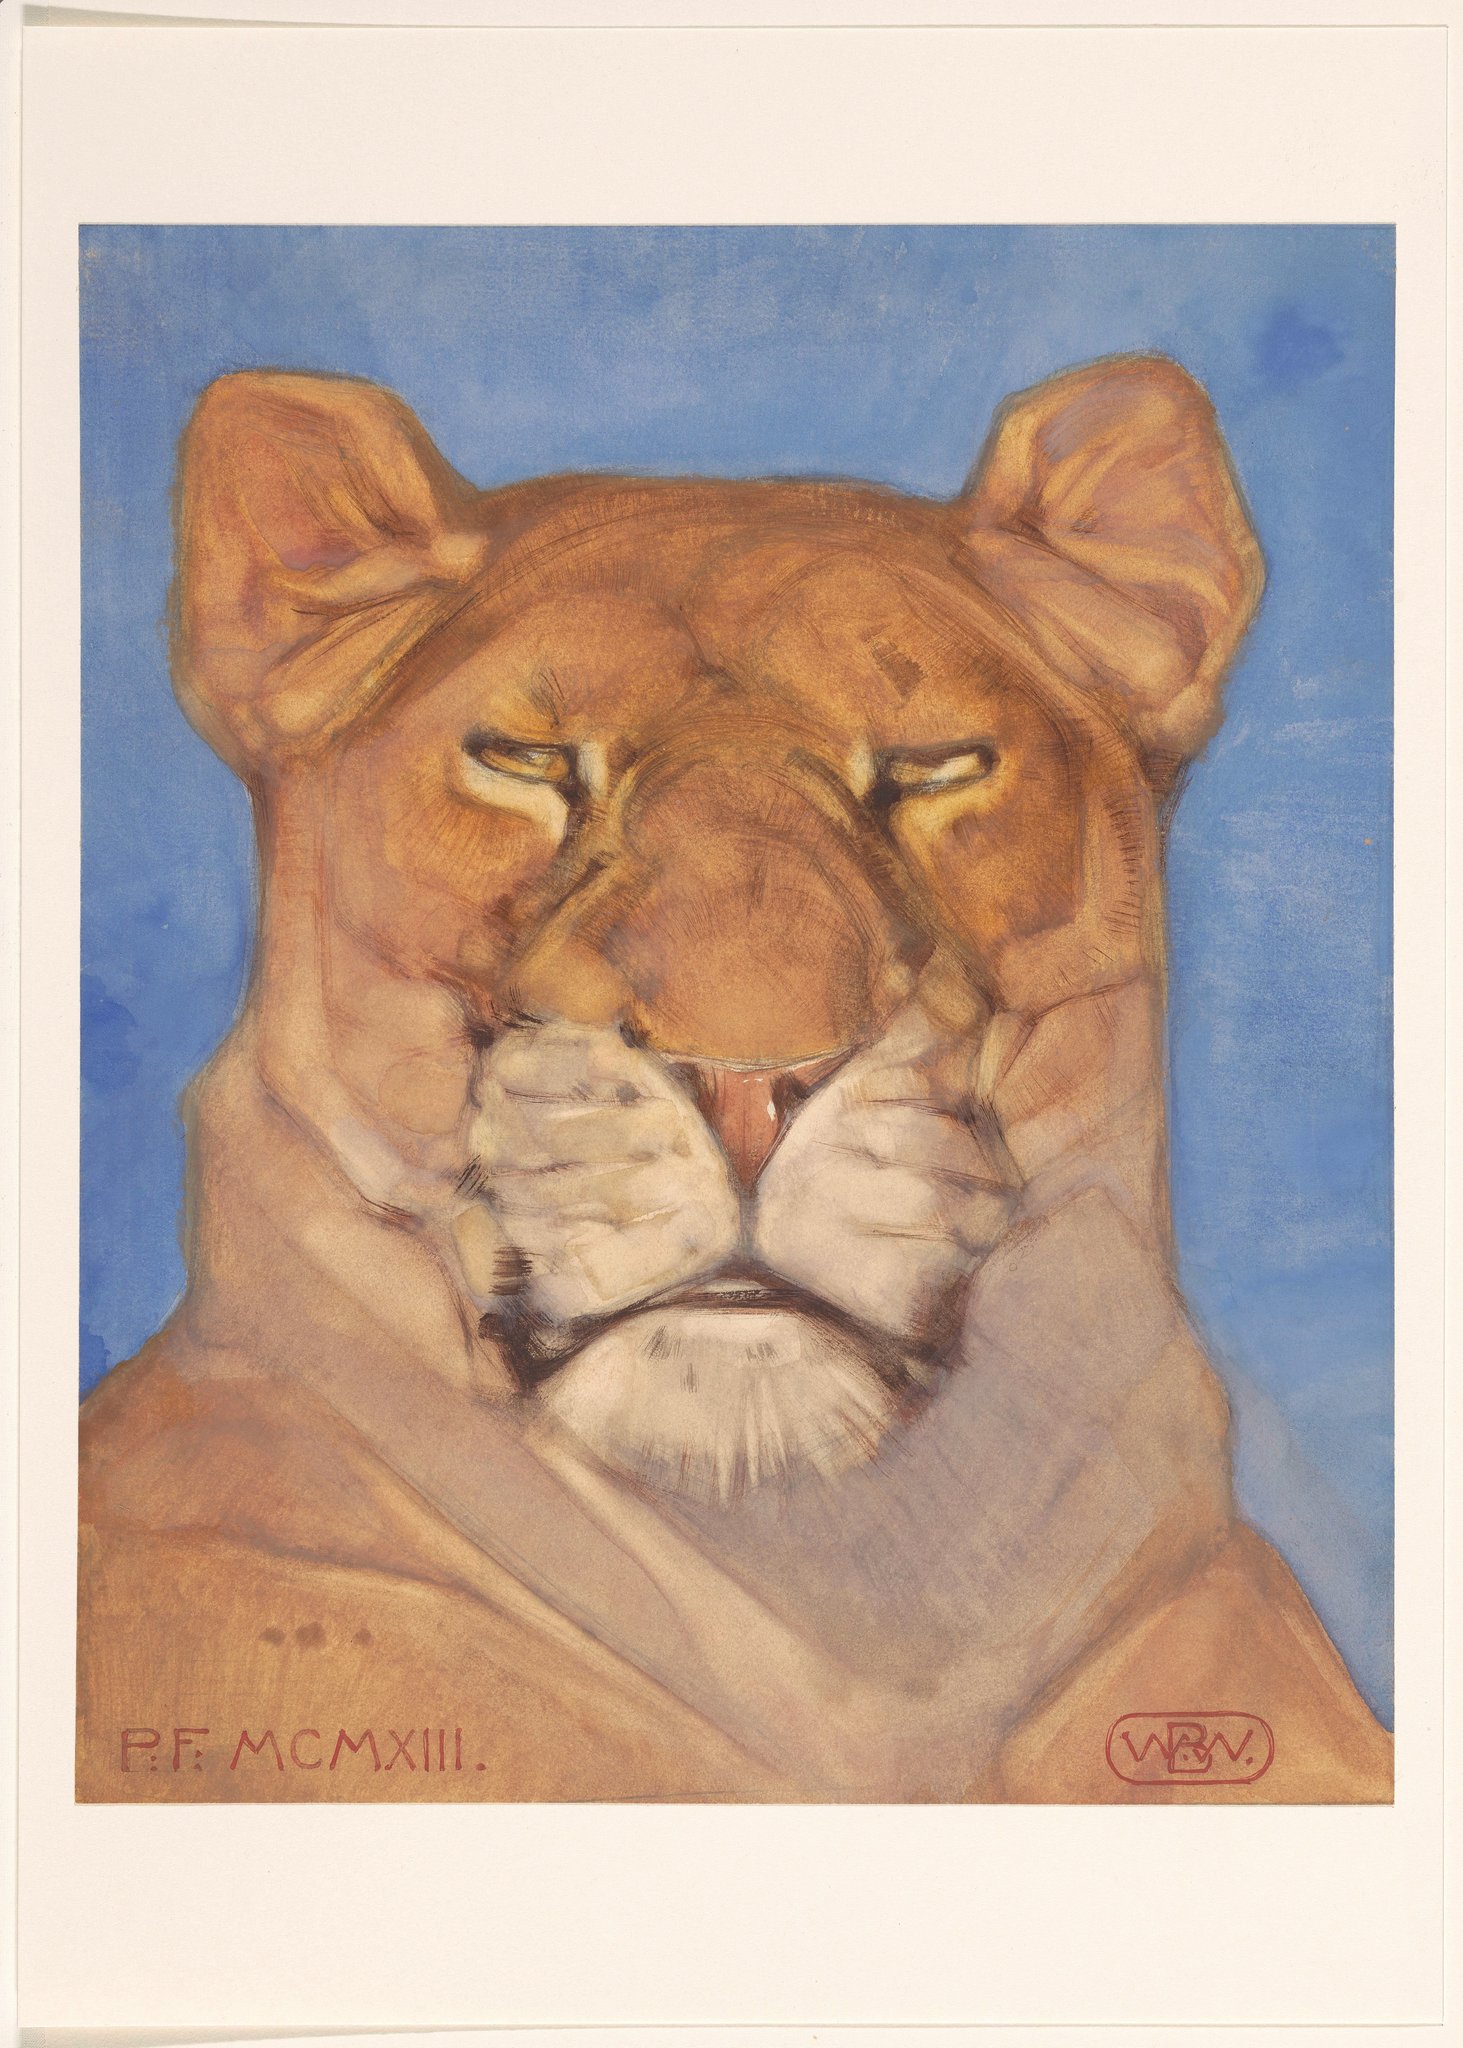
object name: watercolor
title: Kop van een leeuwin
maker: bernard willem wierink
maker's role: draughtsman, print maker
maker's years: 1856-1939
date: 1866-1939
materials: paper, pencil, watercolor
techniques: brush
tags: beasts of prey, predatory animals: lion (+ head of an animal)